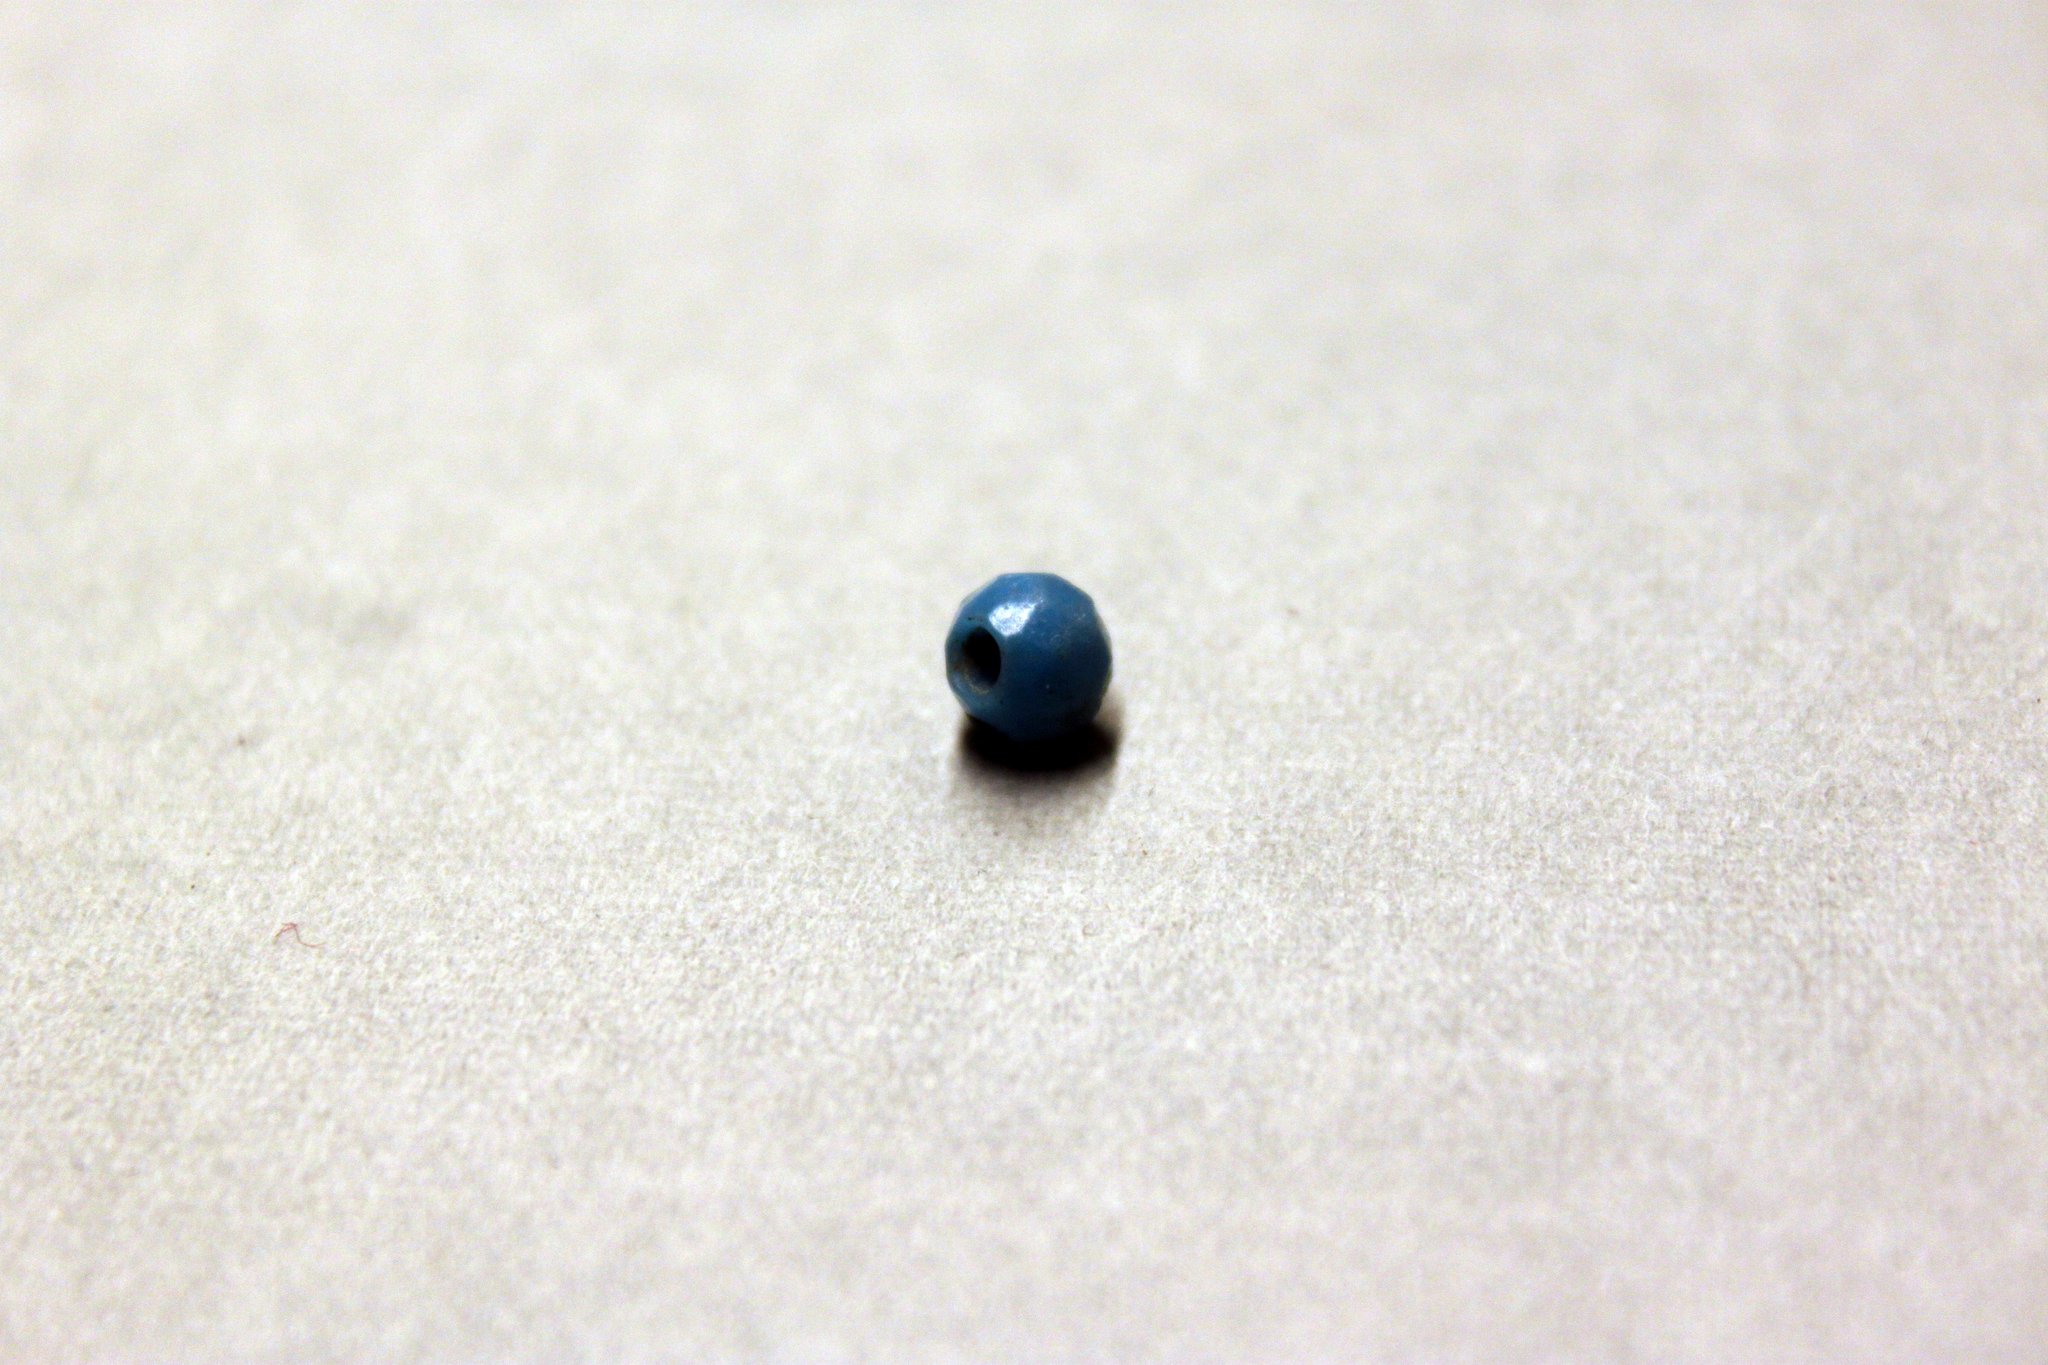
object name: bead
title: Beads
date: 701-1300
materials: glass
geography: iran